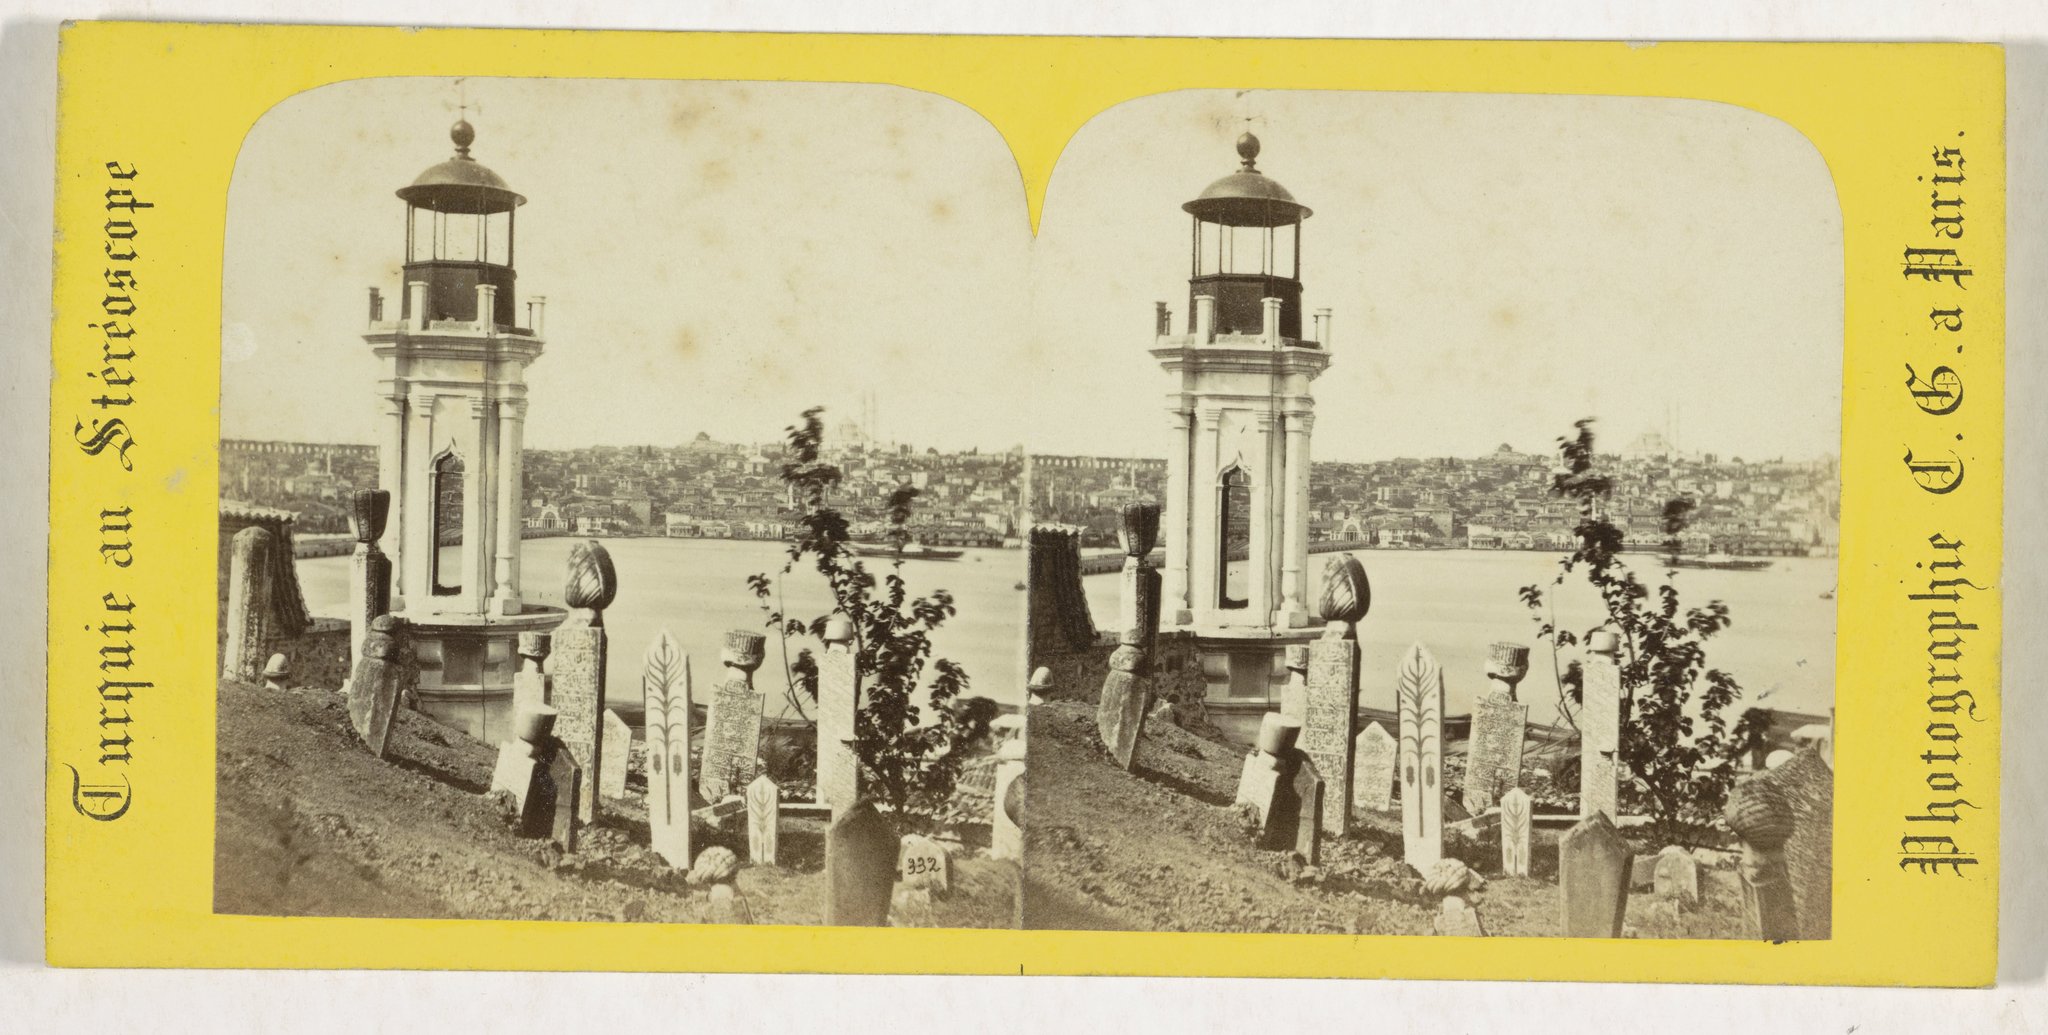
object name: stereograph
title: Turquie au Stéréoscope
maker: charles gaudin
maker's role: publisher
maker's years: 1825-1905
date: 1861-1870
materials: cardboard, paper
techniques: albumen print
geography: eyüp cemetery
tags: cemetery, park-like burying ground, eyüp cemetery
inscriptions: number: ‘332’